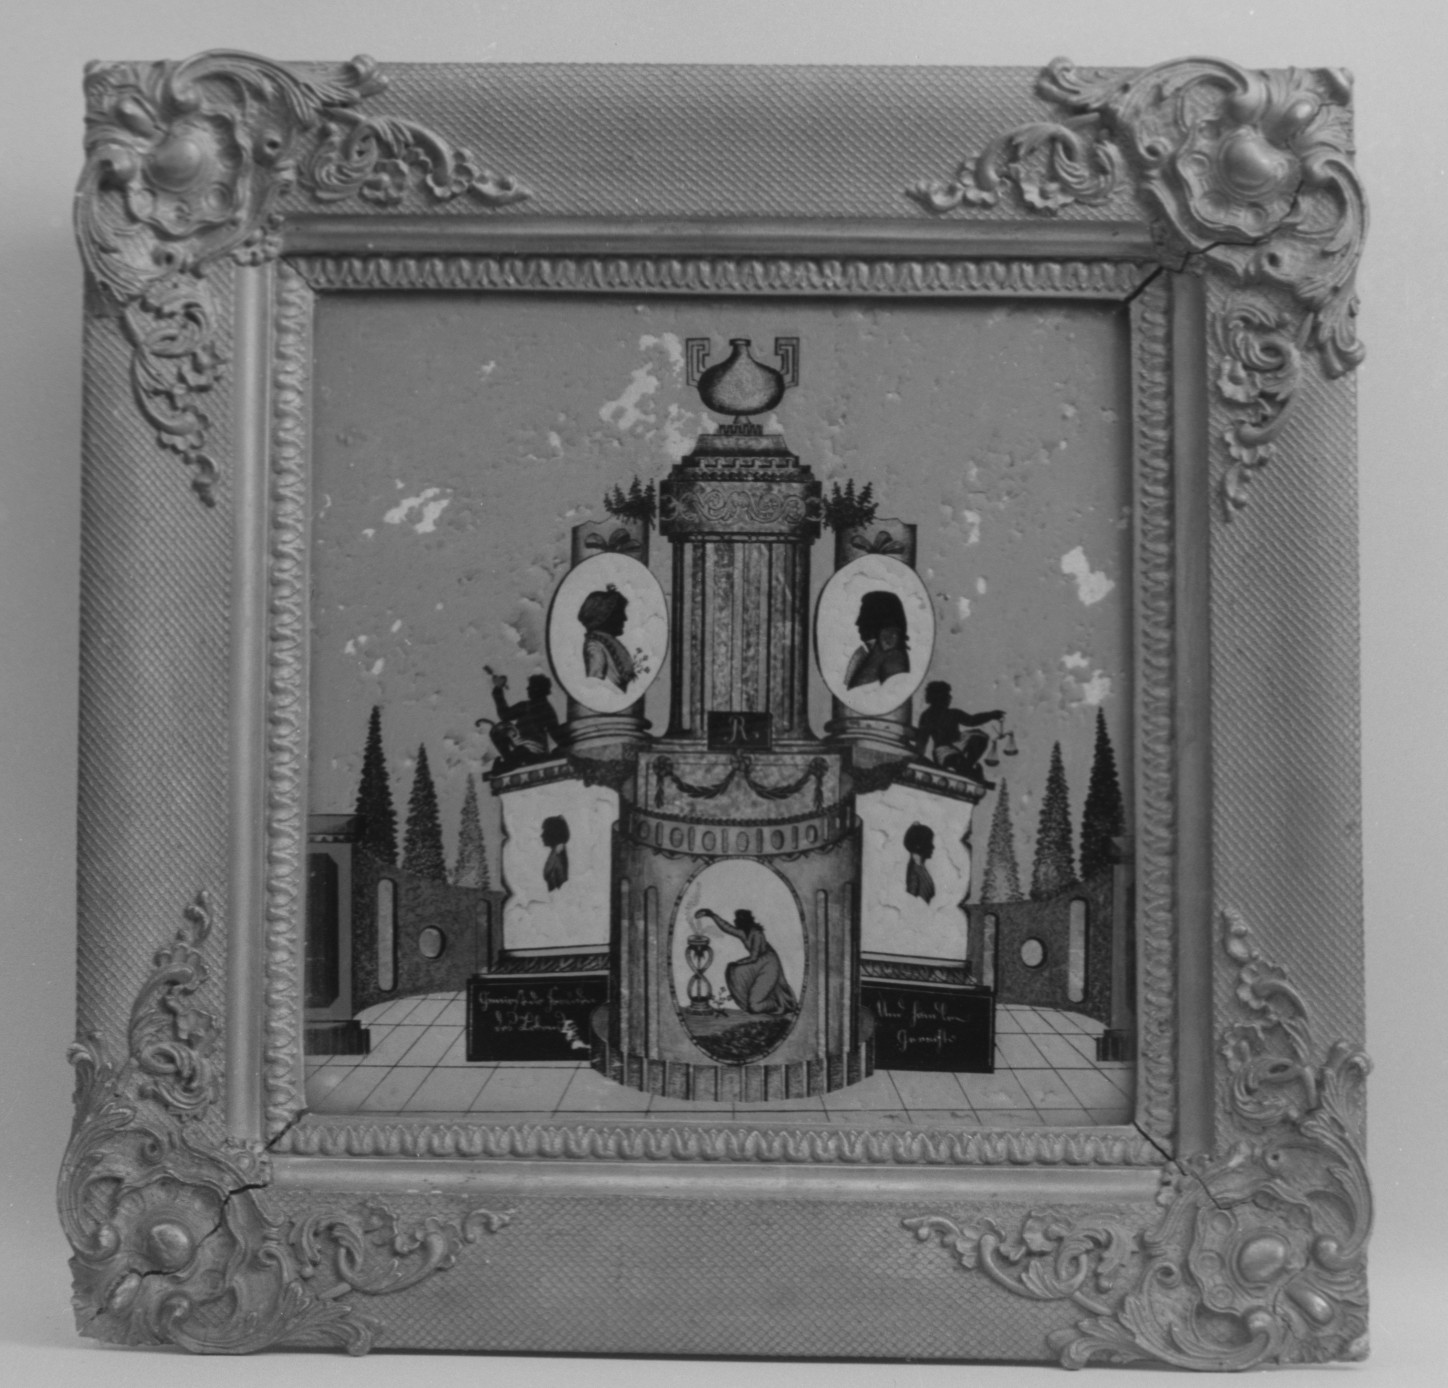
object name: panel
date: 1767-1800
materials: glass